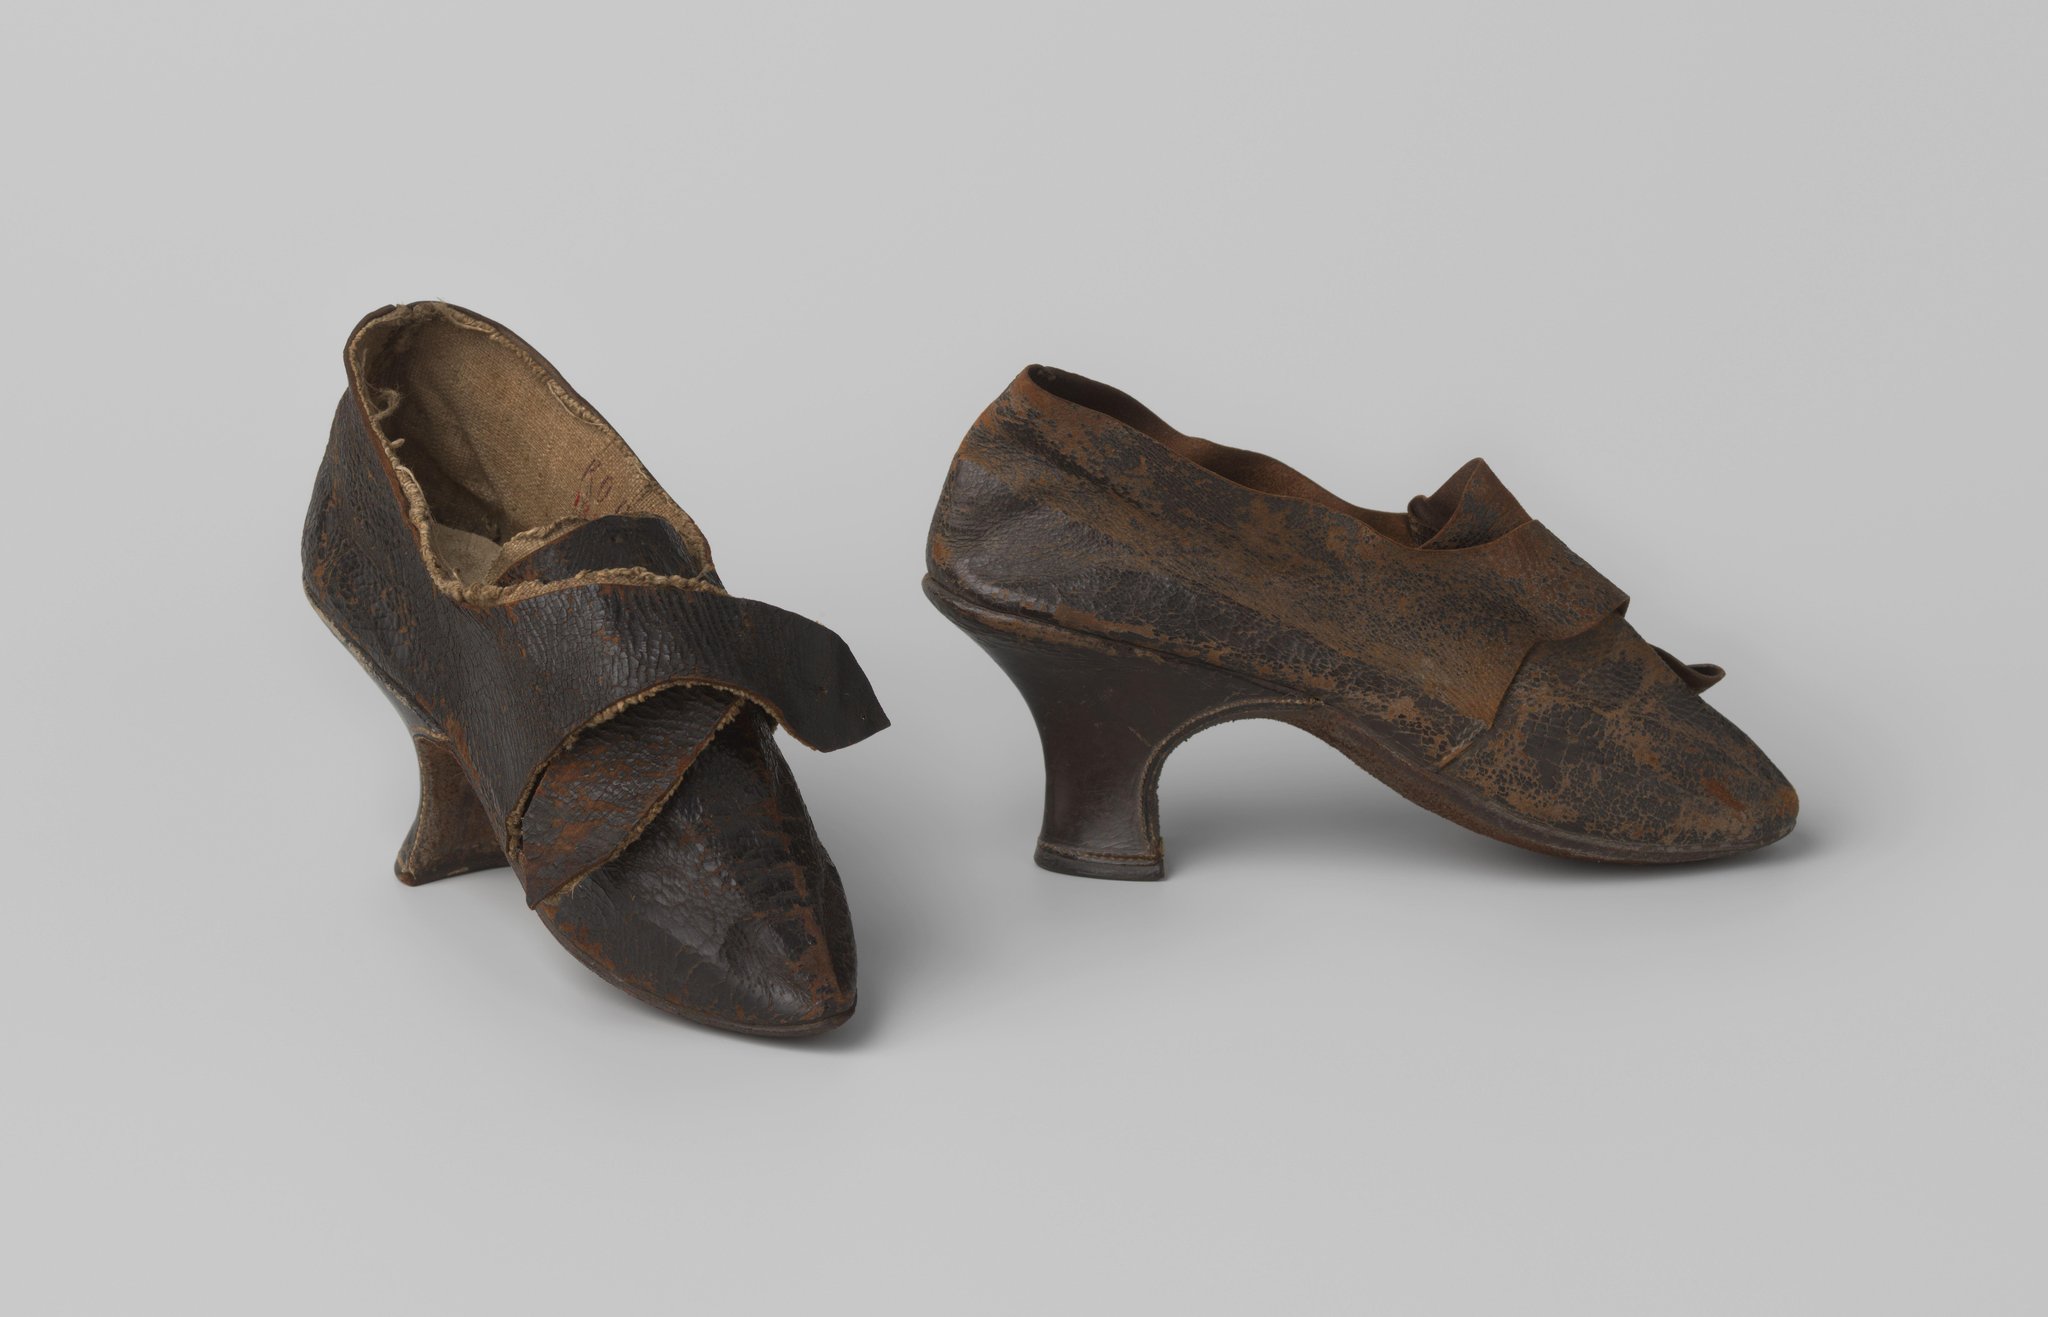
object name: shoe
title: Schoen van zwart leer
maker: Anonymous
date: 1775-1800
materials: leather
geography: northern netherlands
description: Schoen van zwart leer. Model: afgeronde neus, uit drie bladen: een voorblad hoog gesloten in een vierkante tong over de wreef en twee zijbladen uitlopend in twee flappen waarvan een met perforatie ter bevesting van een gesp. De voorkant van de hak loopt in een afgeronde hoek recht naar beneden. De zijkant en achterkant van de hak zijn iets getailleerd en bekleed met leer. De hak heeft een donkerbruine rand leer van het achterflapje.